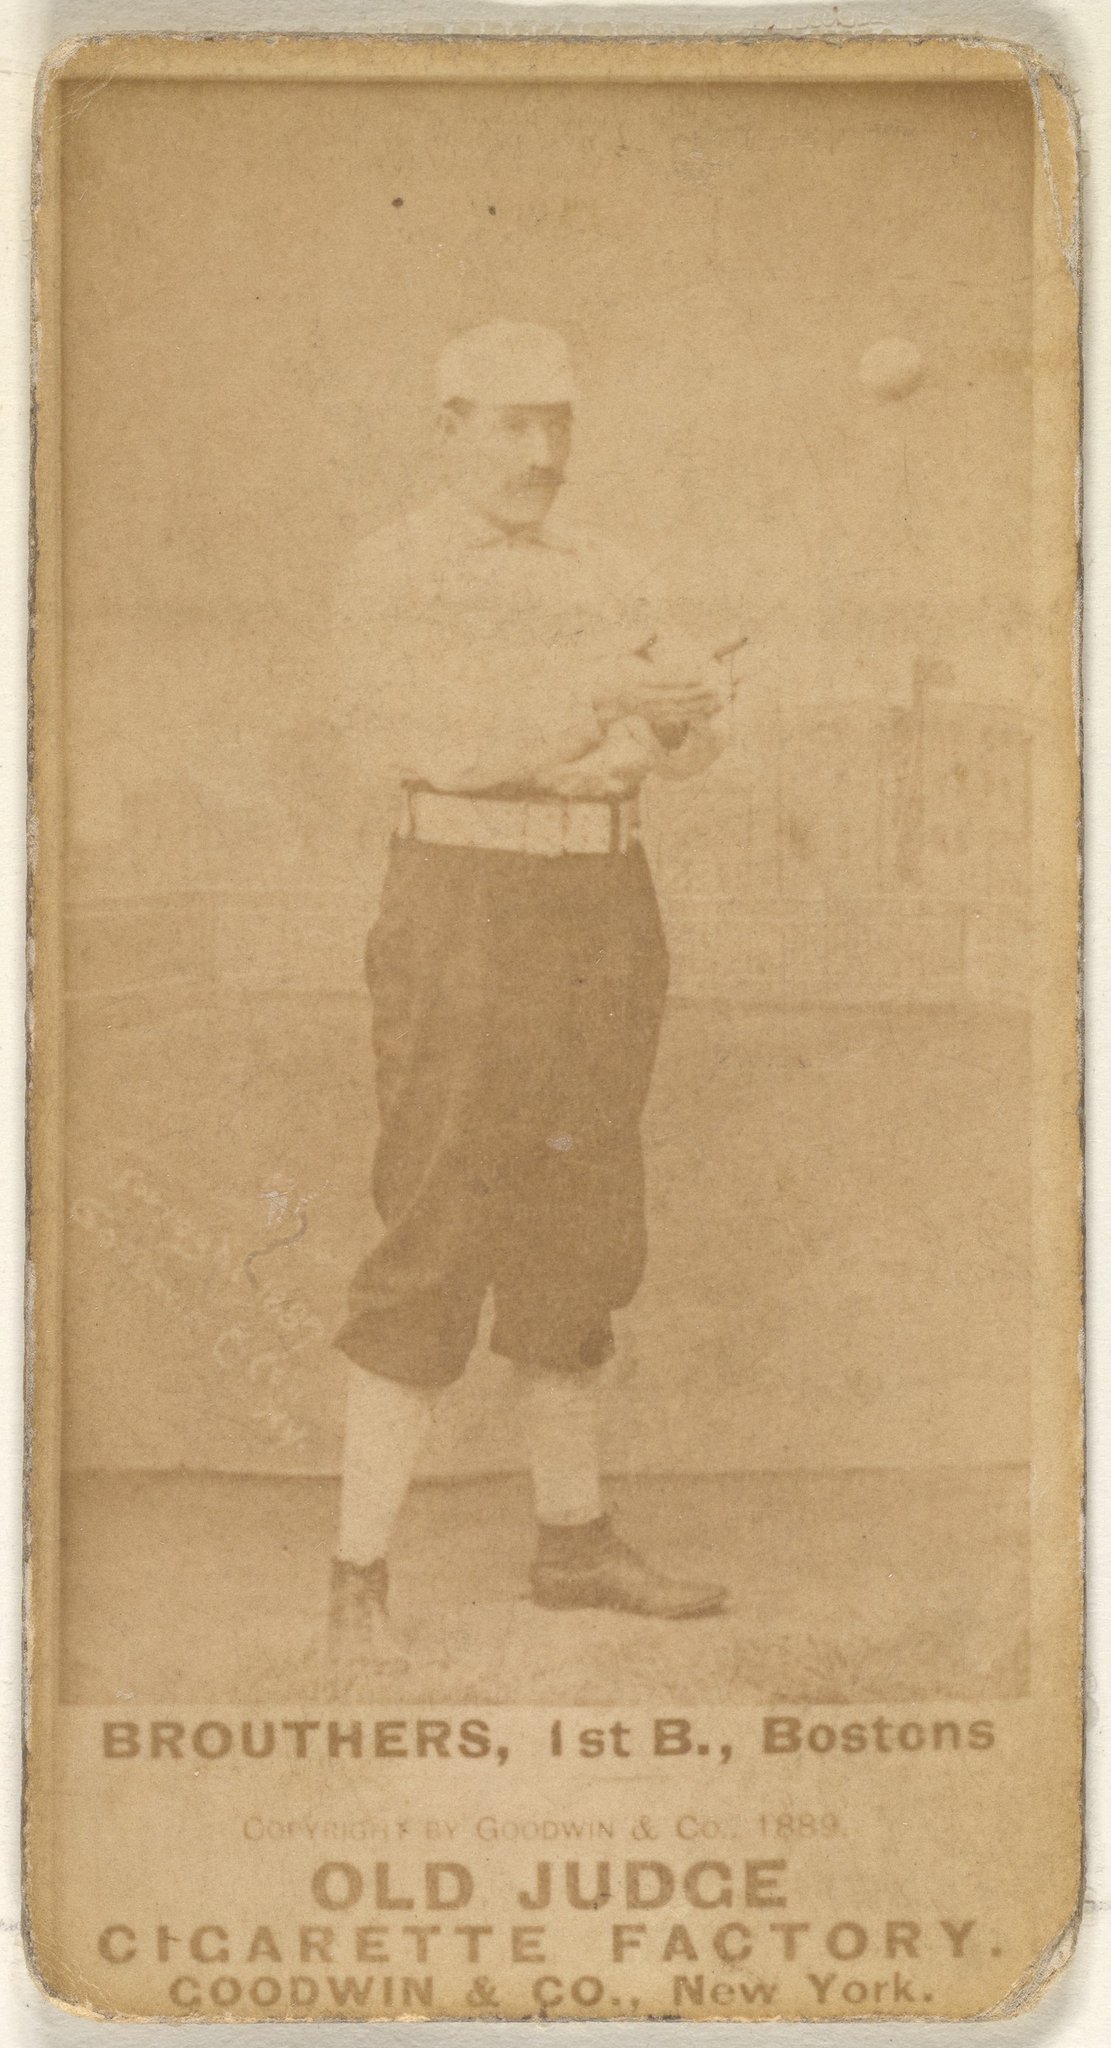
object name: baseball card, photograph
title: Brouthers, 1st Base, Boston, from the Old Judge series (N172) for Old Judge Cigarettes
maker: goodwin & company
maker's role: publisher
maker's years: 1850-1950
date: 1889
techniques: albumen silver print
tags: men,portraits,baseball,athletes